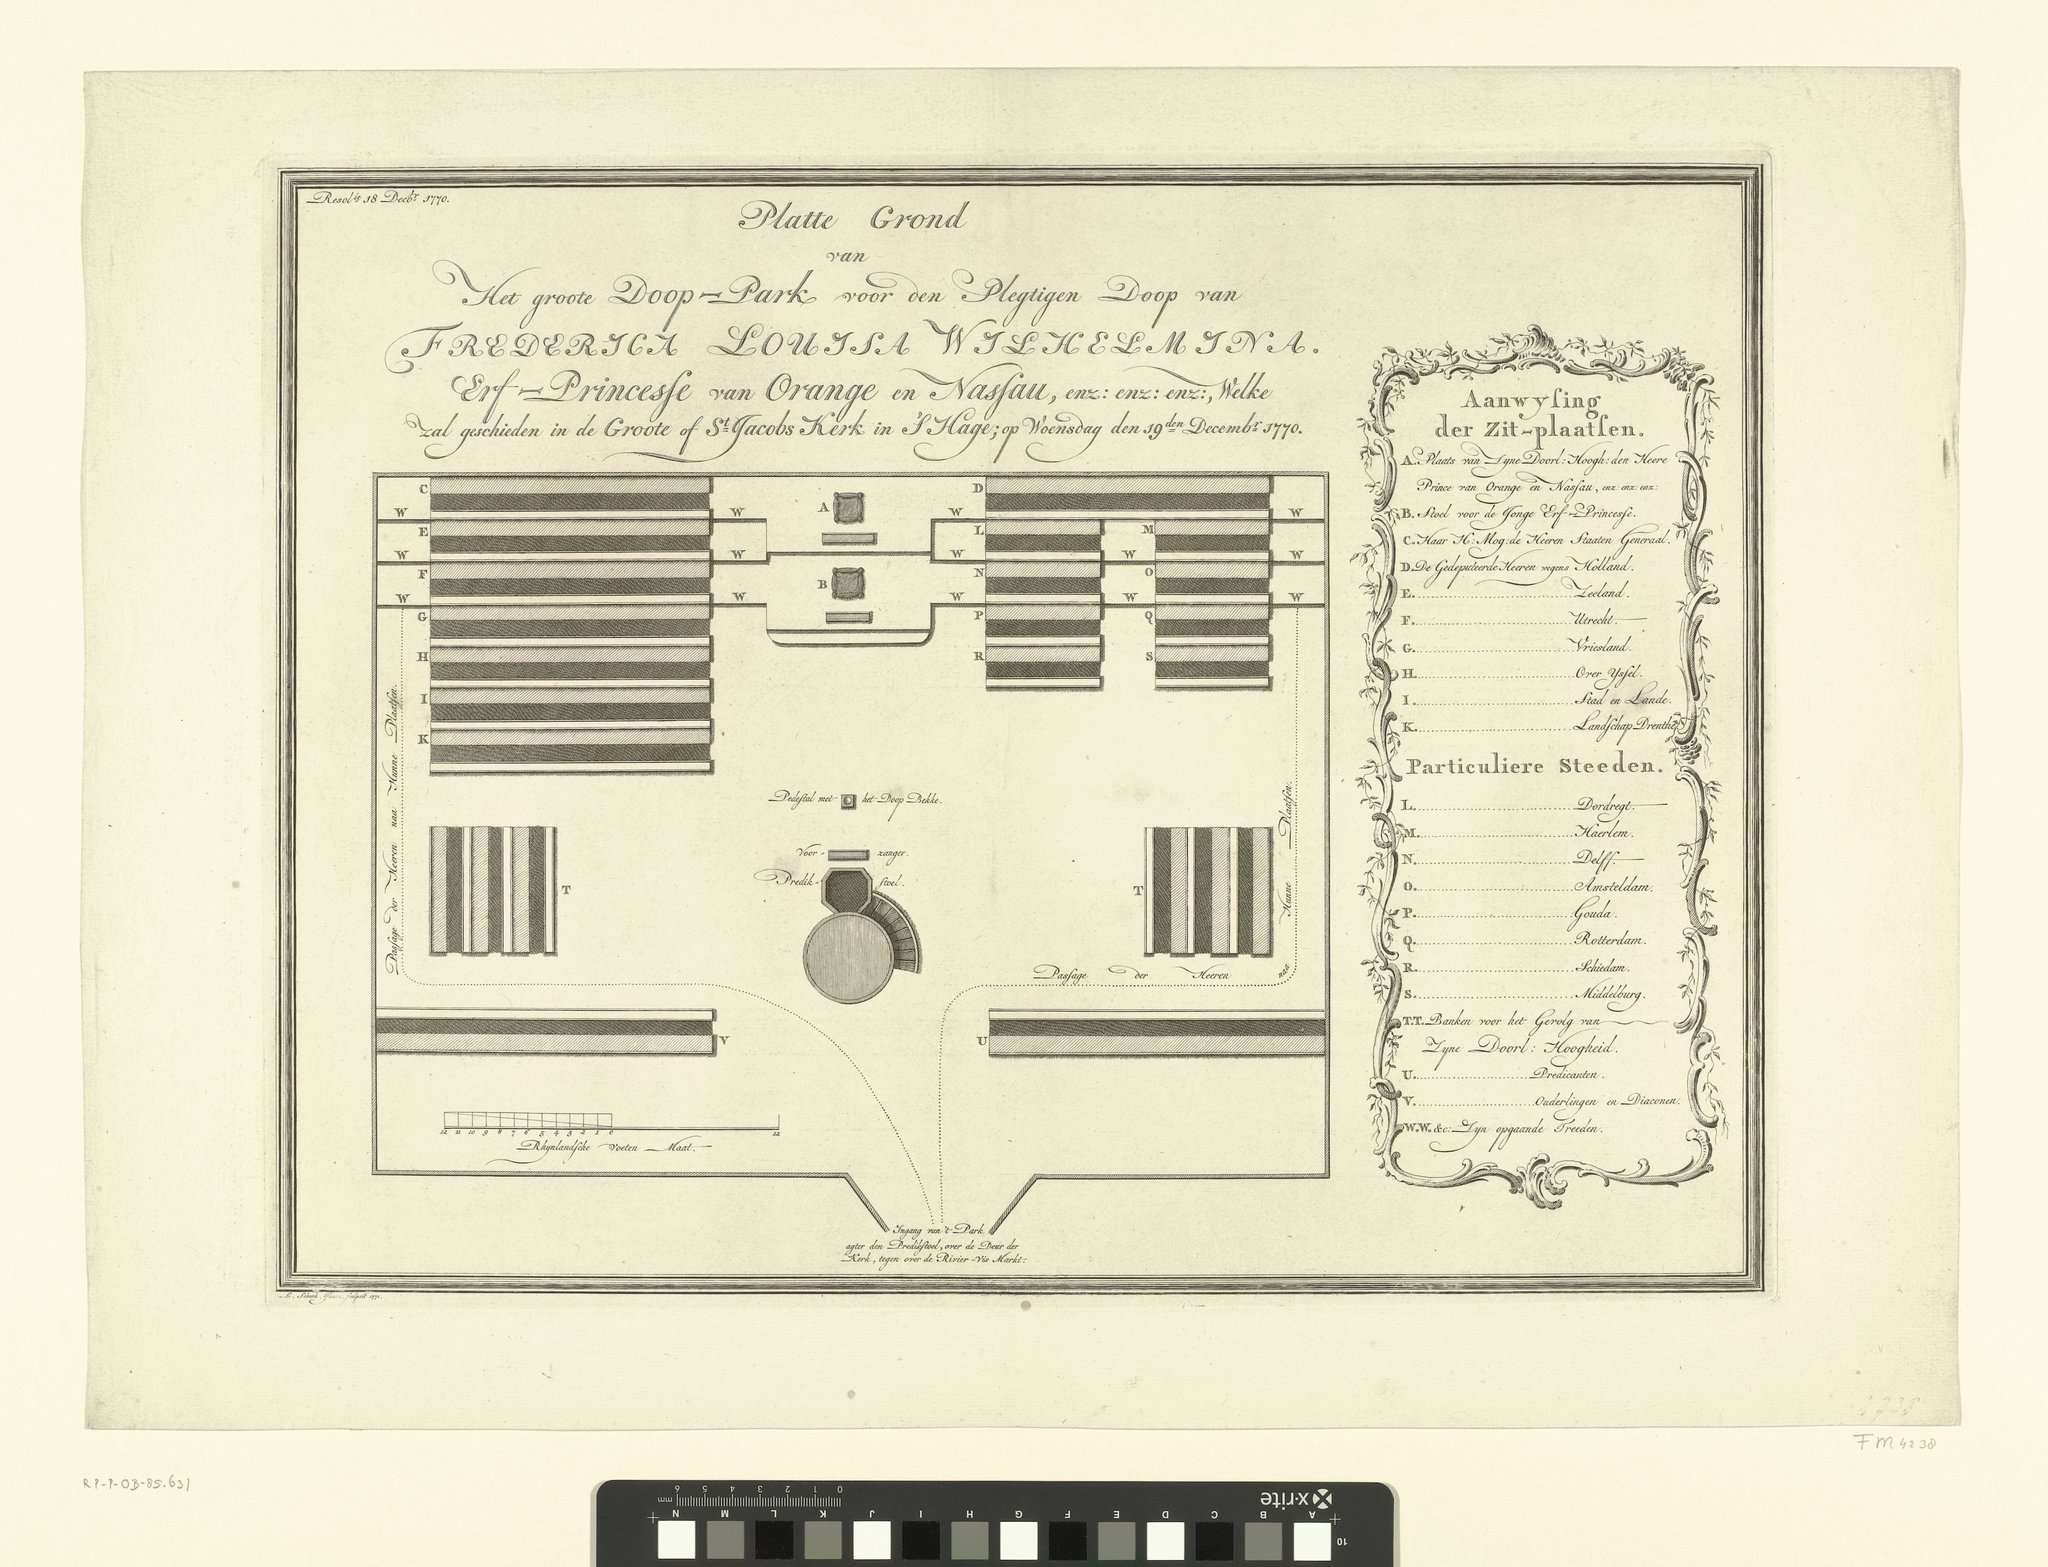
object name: print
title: Platte grond van het groote doop-park voor den plegtigen doop van Frederica Louisa Wilhelmina. Erf-princesse van Orange en Nassau, enz: enz: enz:, welke zal geschieden in de Groote of St. Jacobs Kerk in 's Hage; op woensdag den 19den decembr. 1770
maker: leonardus schenk jansz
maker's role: print maker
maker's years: 1732-1800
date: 1771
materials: paper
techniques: engraving, etching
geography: northern netherlands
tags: the hague, louise (prinses van oranje-nassau), baptism ~ protestant service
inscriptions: collector's mark: Lugt 2228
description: Plattegrond met het arrangement van de zitplaatsen bij de doop van prinses Frederica Louise Wilhelmina (Louise) in de Grote Kerk te Den Haag op 19 december 1770. Linksonder een schaalstok: 12 Rhynlandsche voeten maat. Rechts een cartouche met de legenda A-WW per provincie en stad. Rechtsboven gemerkt: Resolie. 18 decbr. 1770.